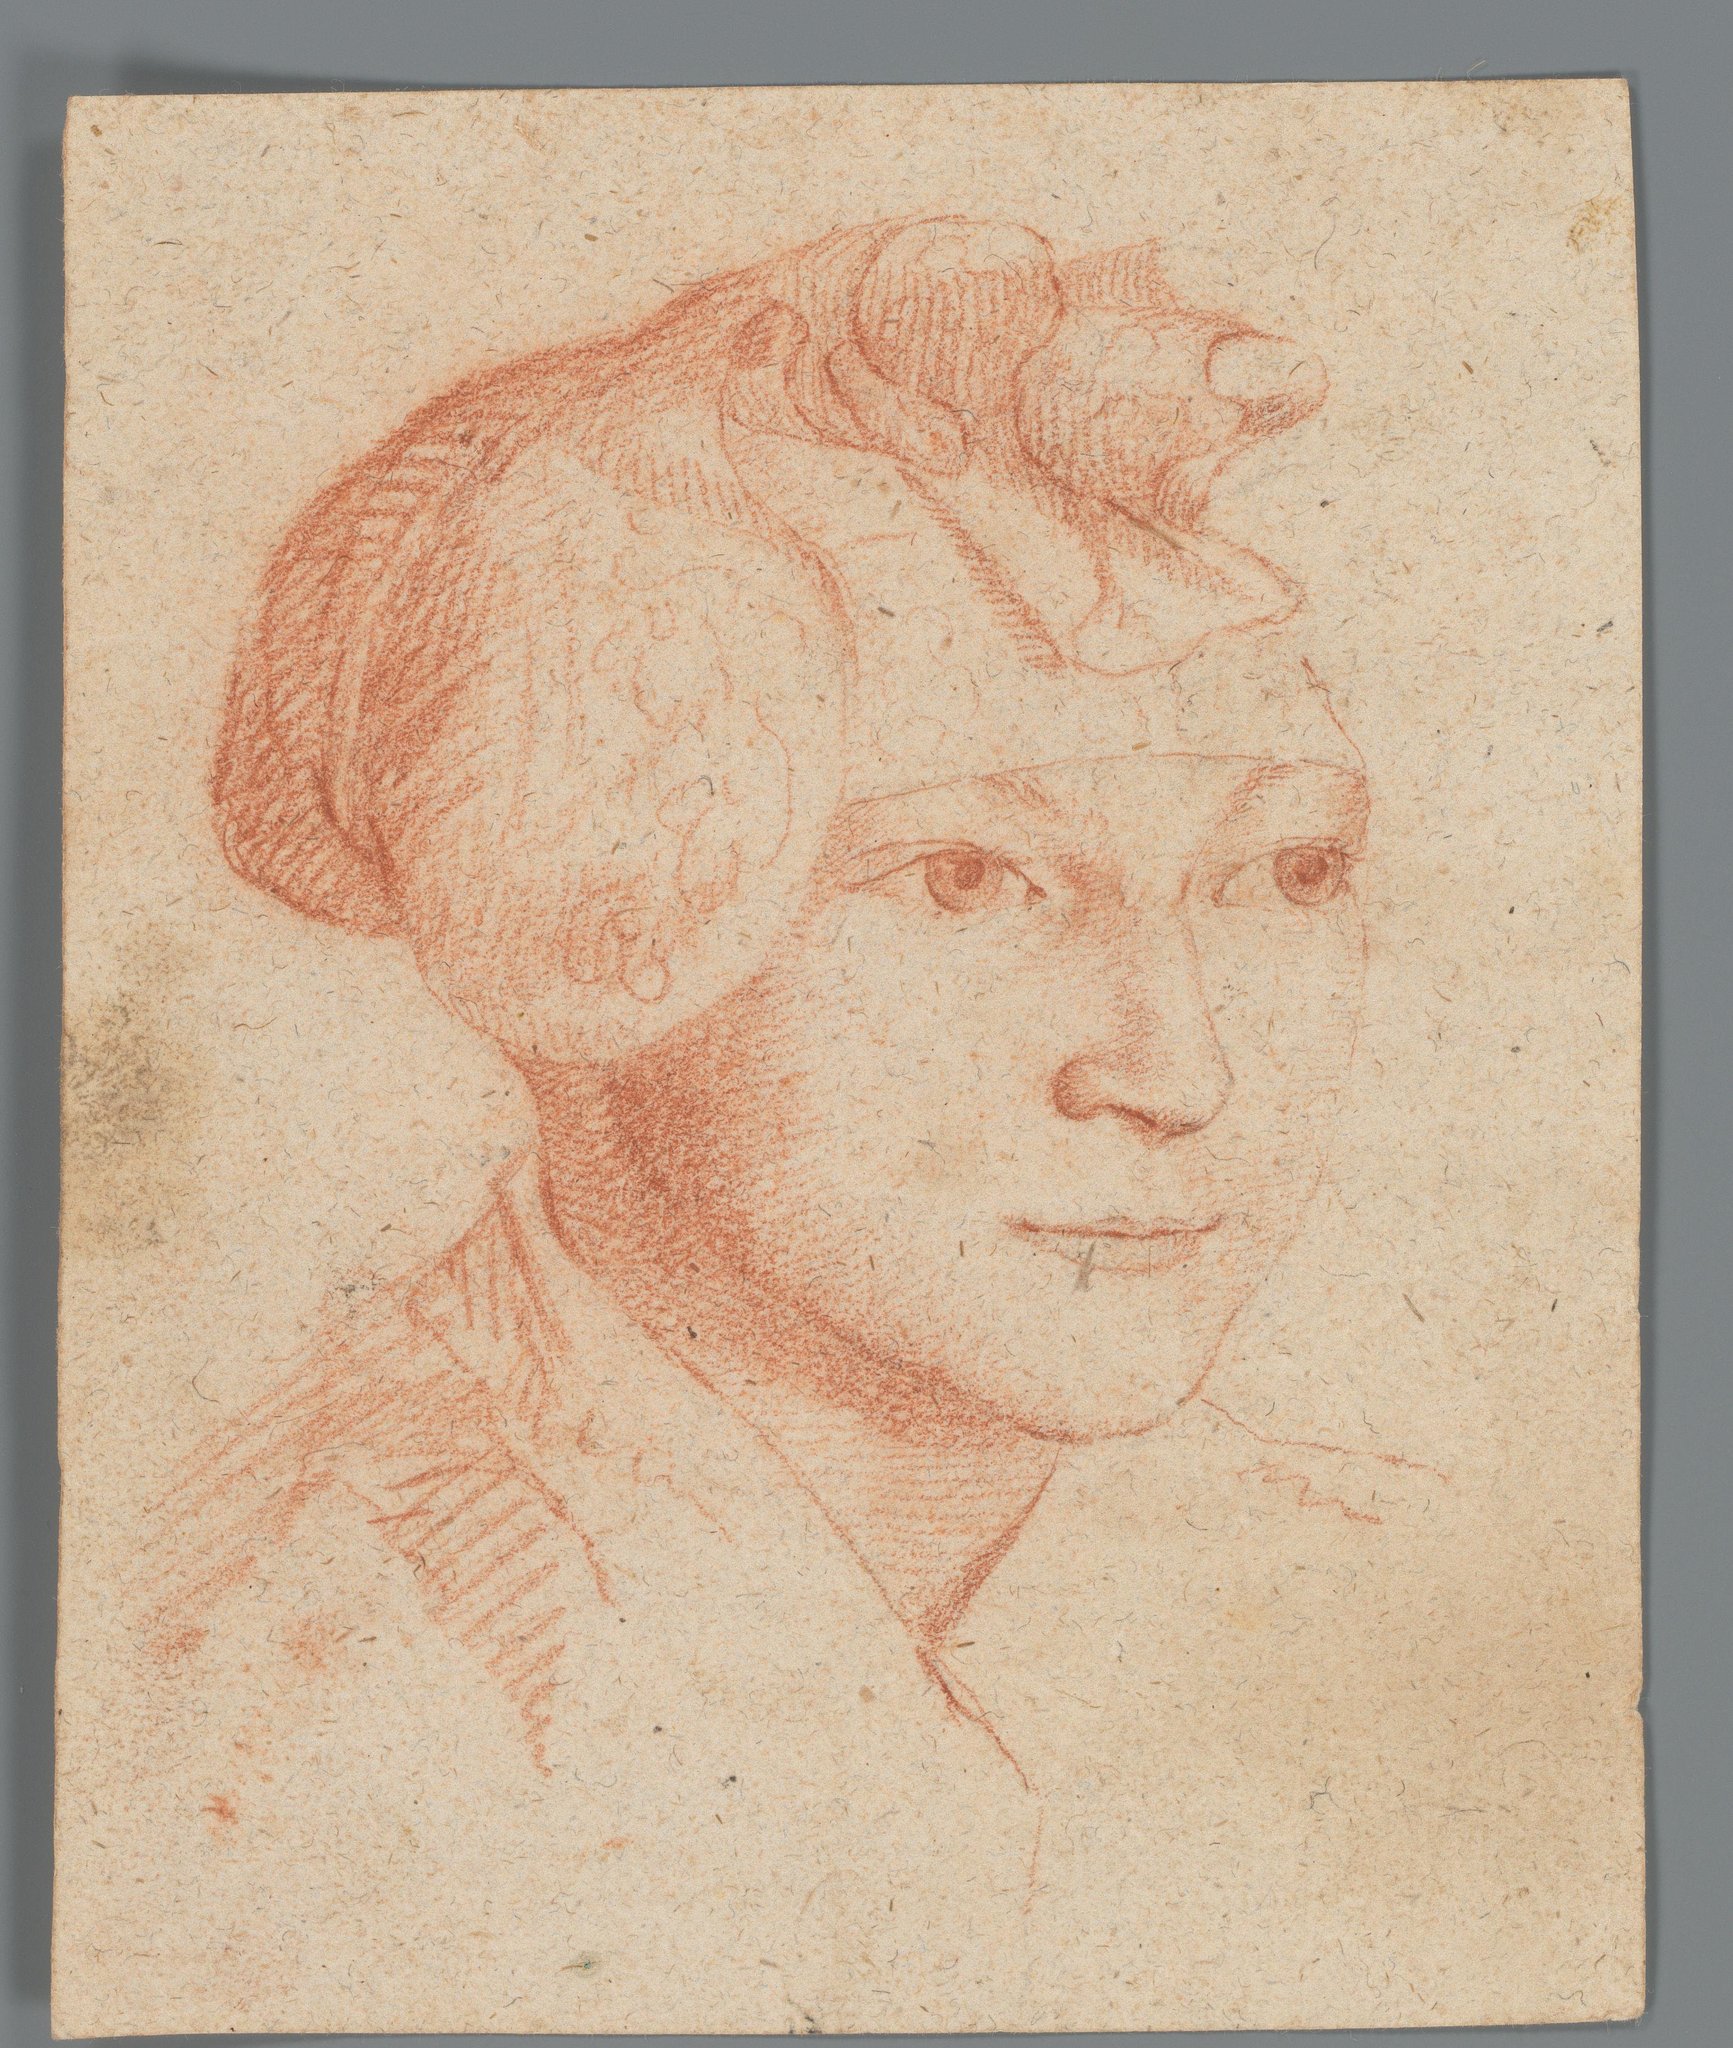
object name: drawing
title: Portret van een vrouw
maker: matthijs balen (1684-1766)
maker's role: draughtsman, painter, print maker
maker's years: 1684-1766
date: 1694-1766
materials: chalk, paper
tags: historical persons not known by name - bb - woman